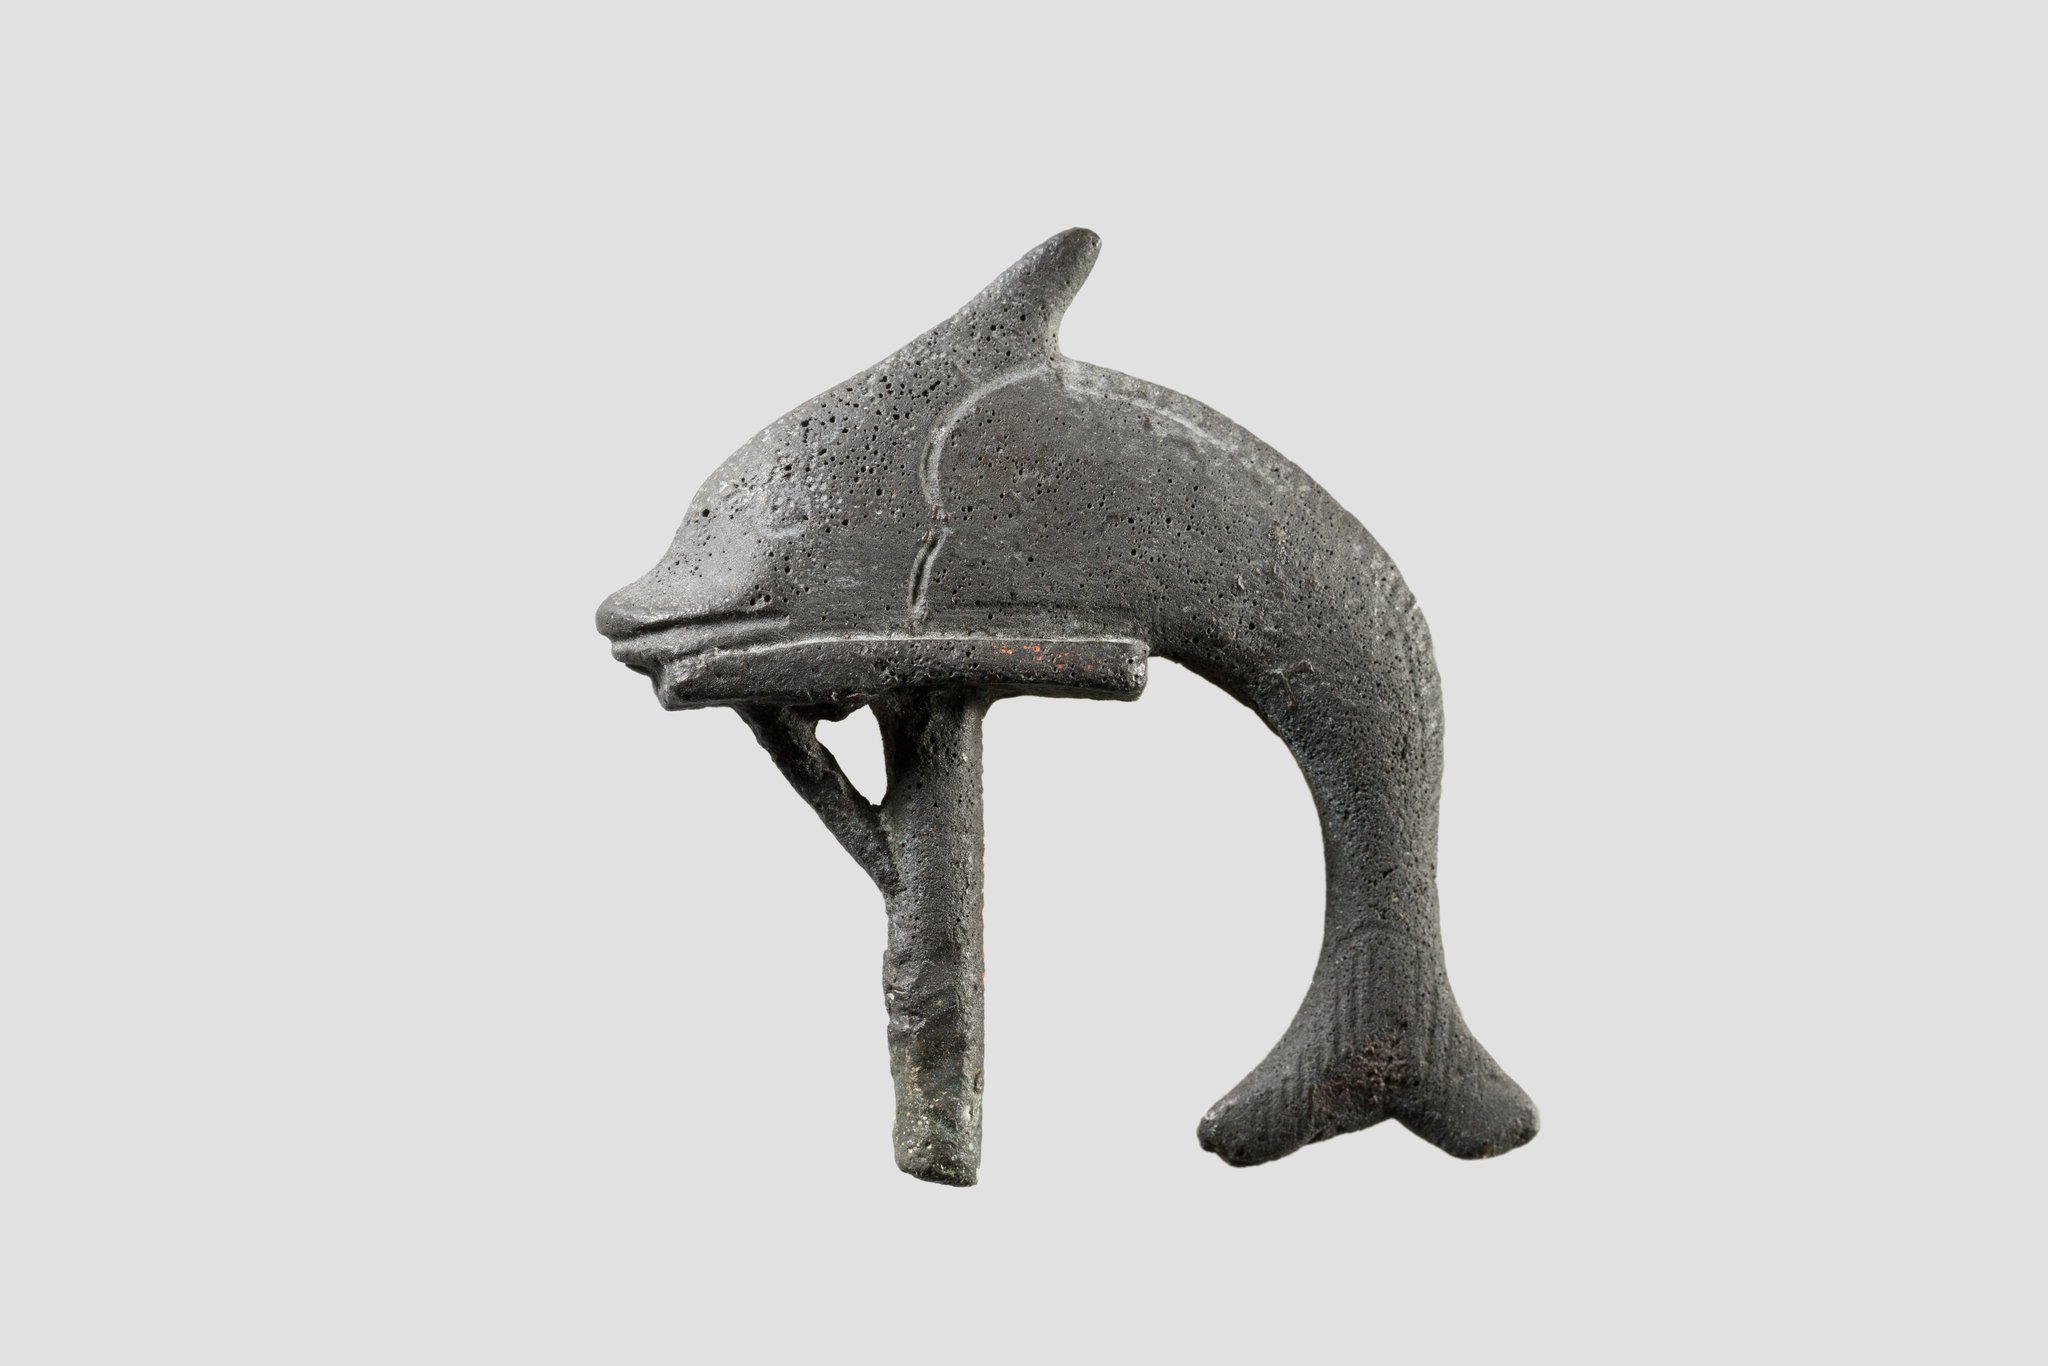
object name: figurine, hatmehyt a standard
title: Schilbe fish, sacred to Hatmehyt, on standard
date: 664-630 BCE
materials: metal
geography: egypt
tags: fish,goddess